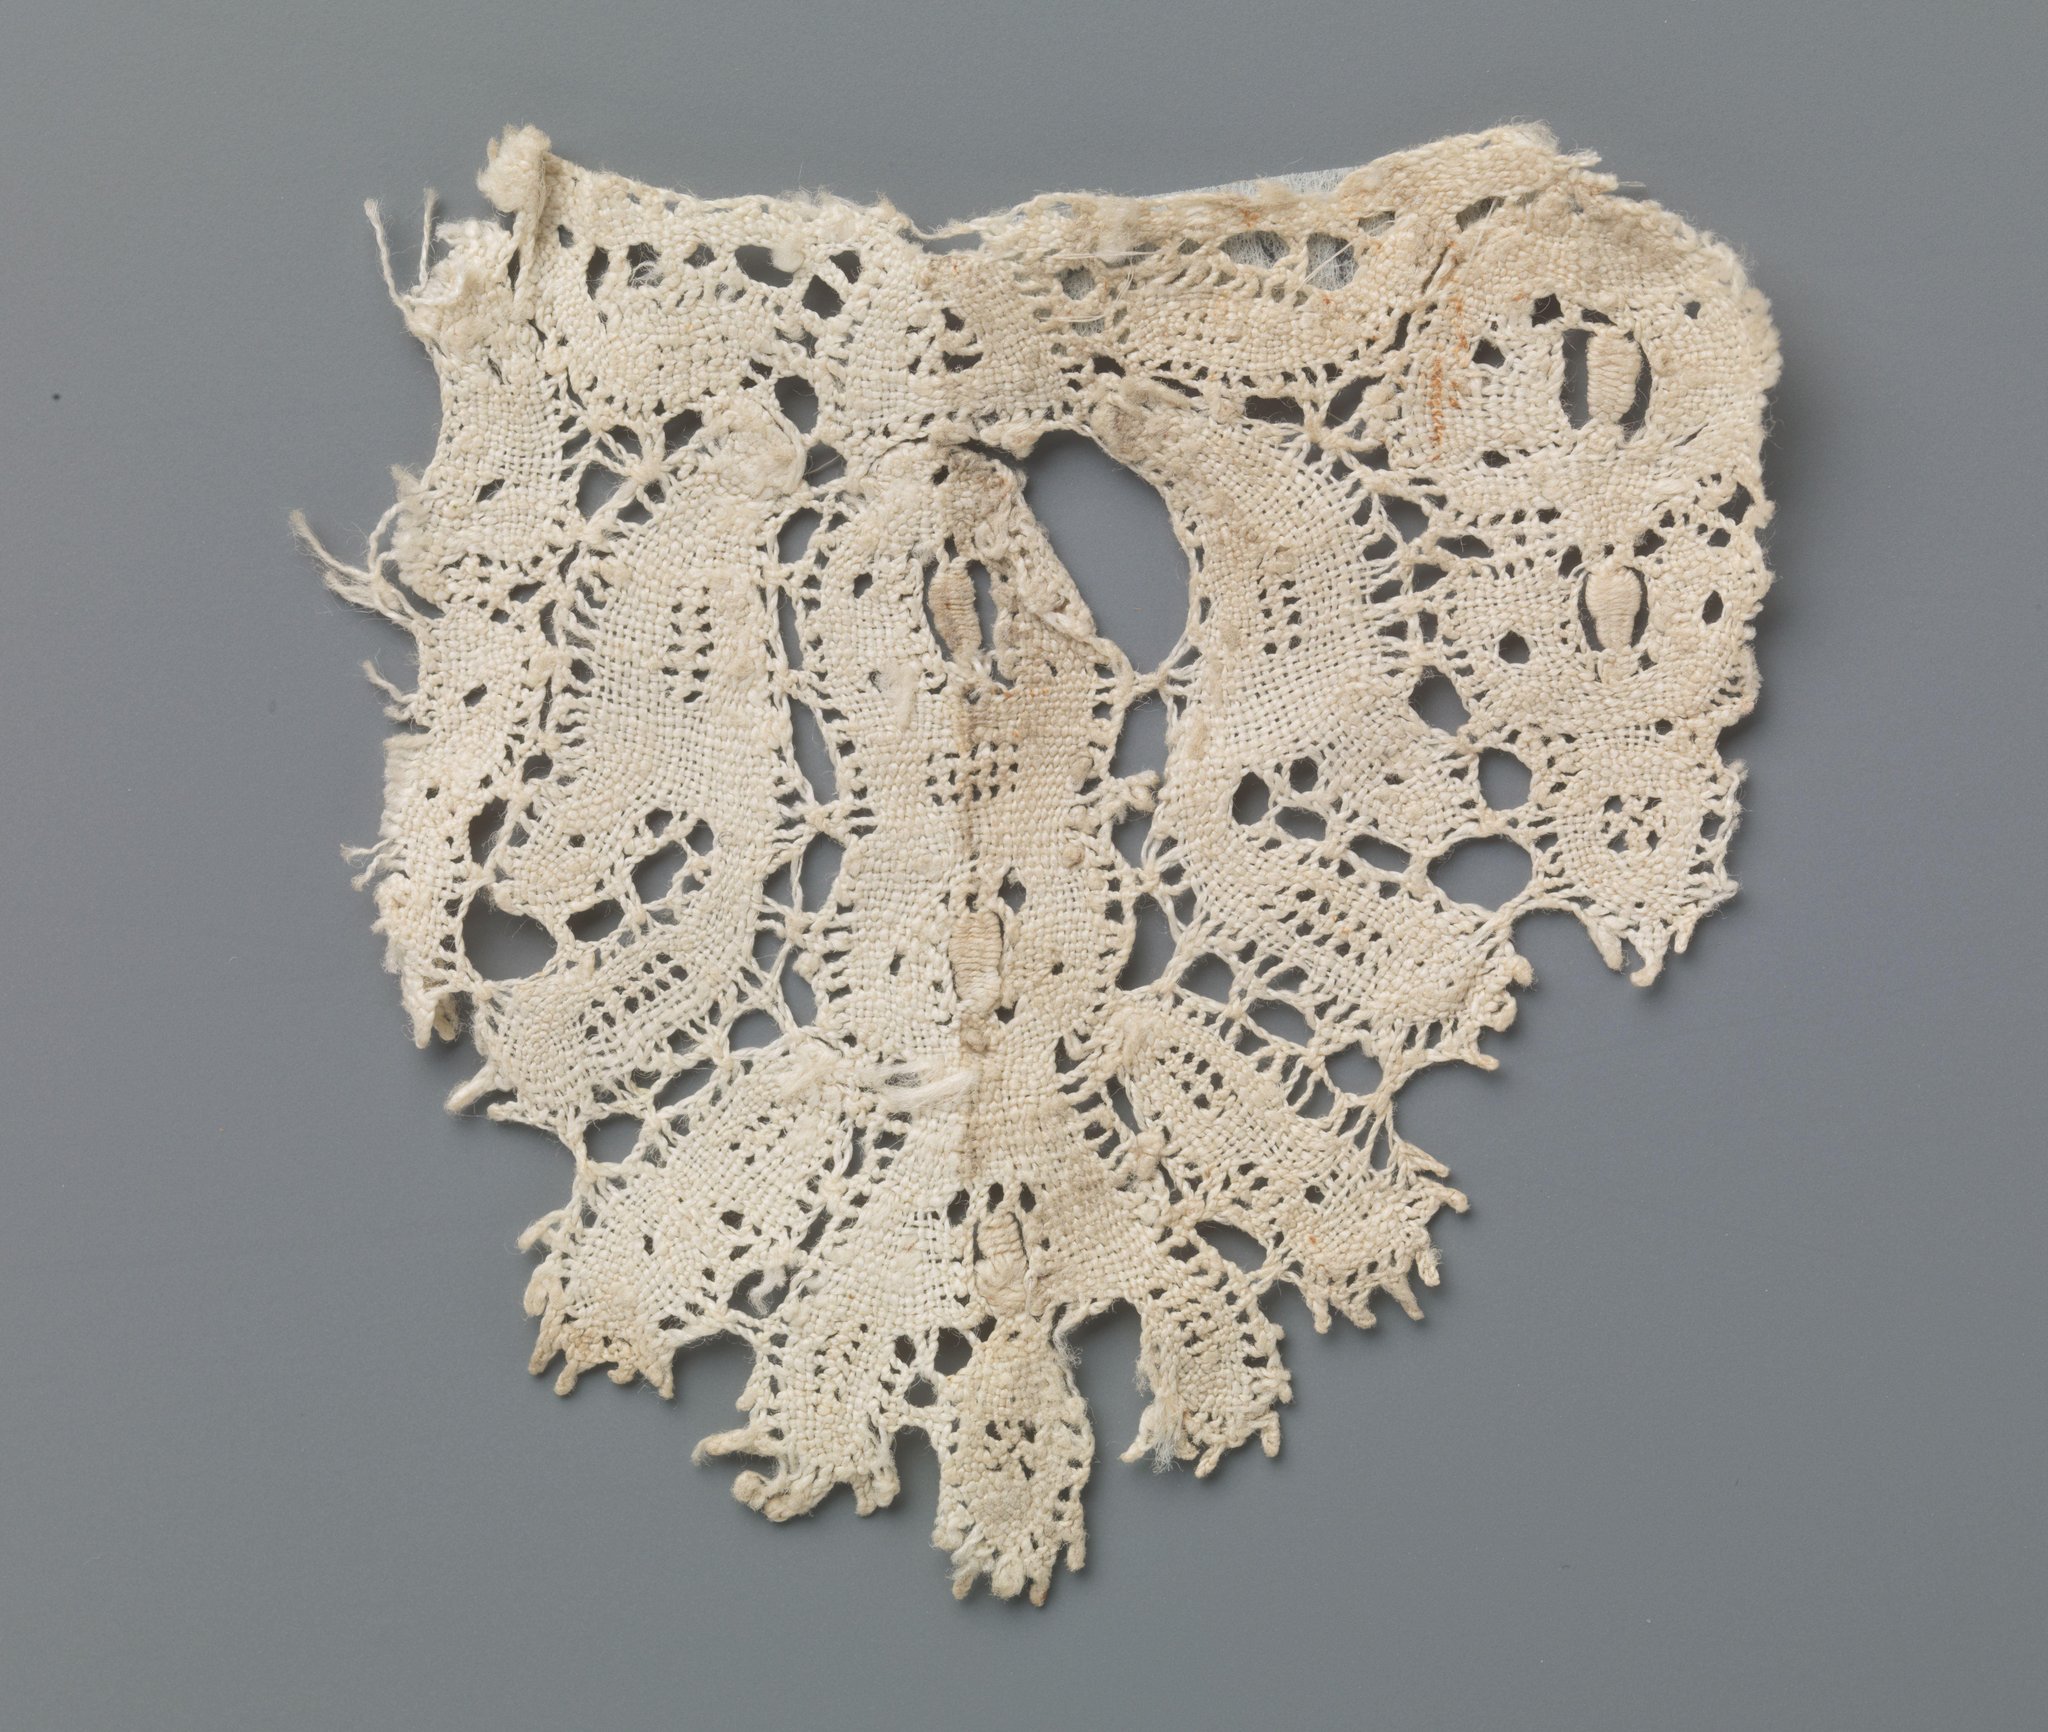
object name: fragment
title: Fragment kloskant bestaande uit één schulp met distel of korenbloem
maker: Anonymous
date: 1625-1649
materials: linen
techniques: lace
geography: southern netherlands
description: Strook naturelkleurige kloskant: oudvlaamse kant. Halfronde schulpen met grillige randen met in elke schulp een symmetrisch patroon met een naar beneden hangende bloem, mogelijk een distel of korenbloem. De motieven zijn gemaakt in linnenslag met opengewerkte randjes en uitsparingen. In de lengte-as zijn in uitsparingen bladvormige kunstslagen toegepast. De bovenzijde van de strook is recht afgewerkt. De schulpenrand is afgewerkt met picots.